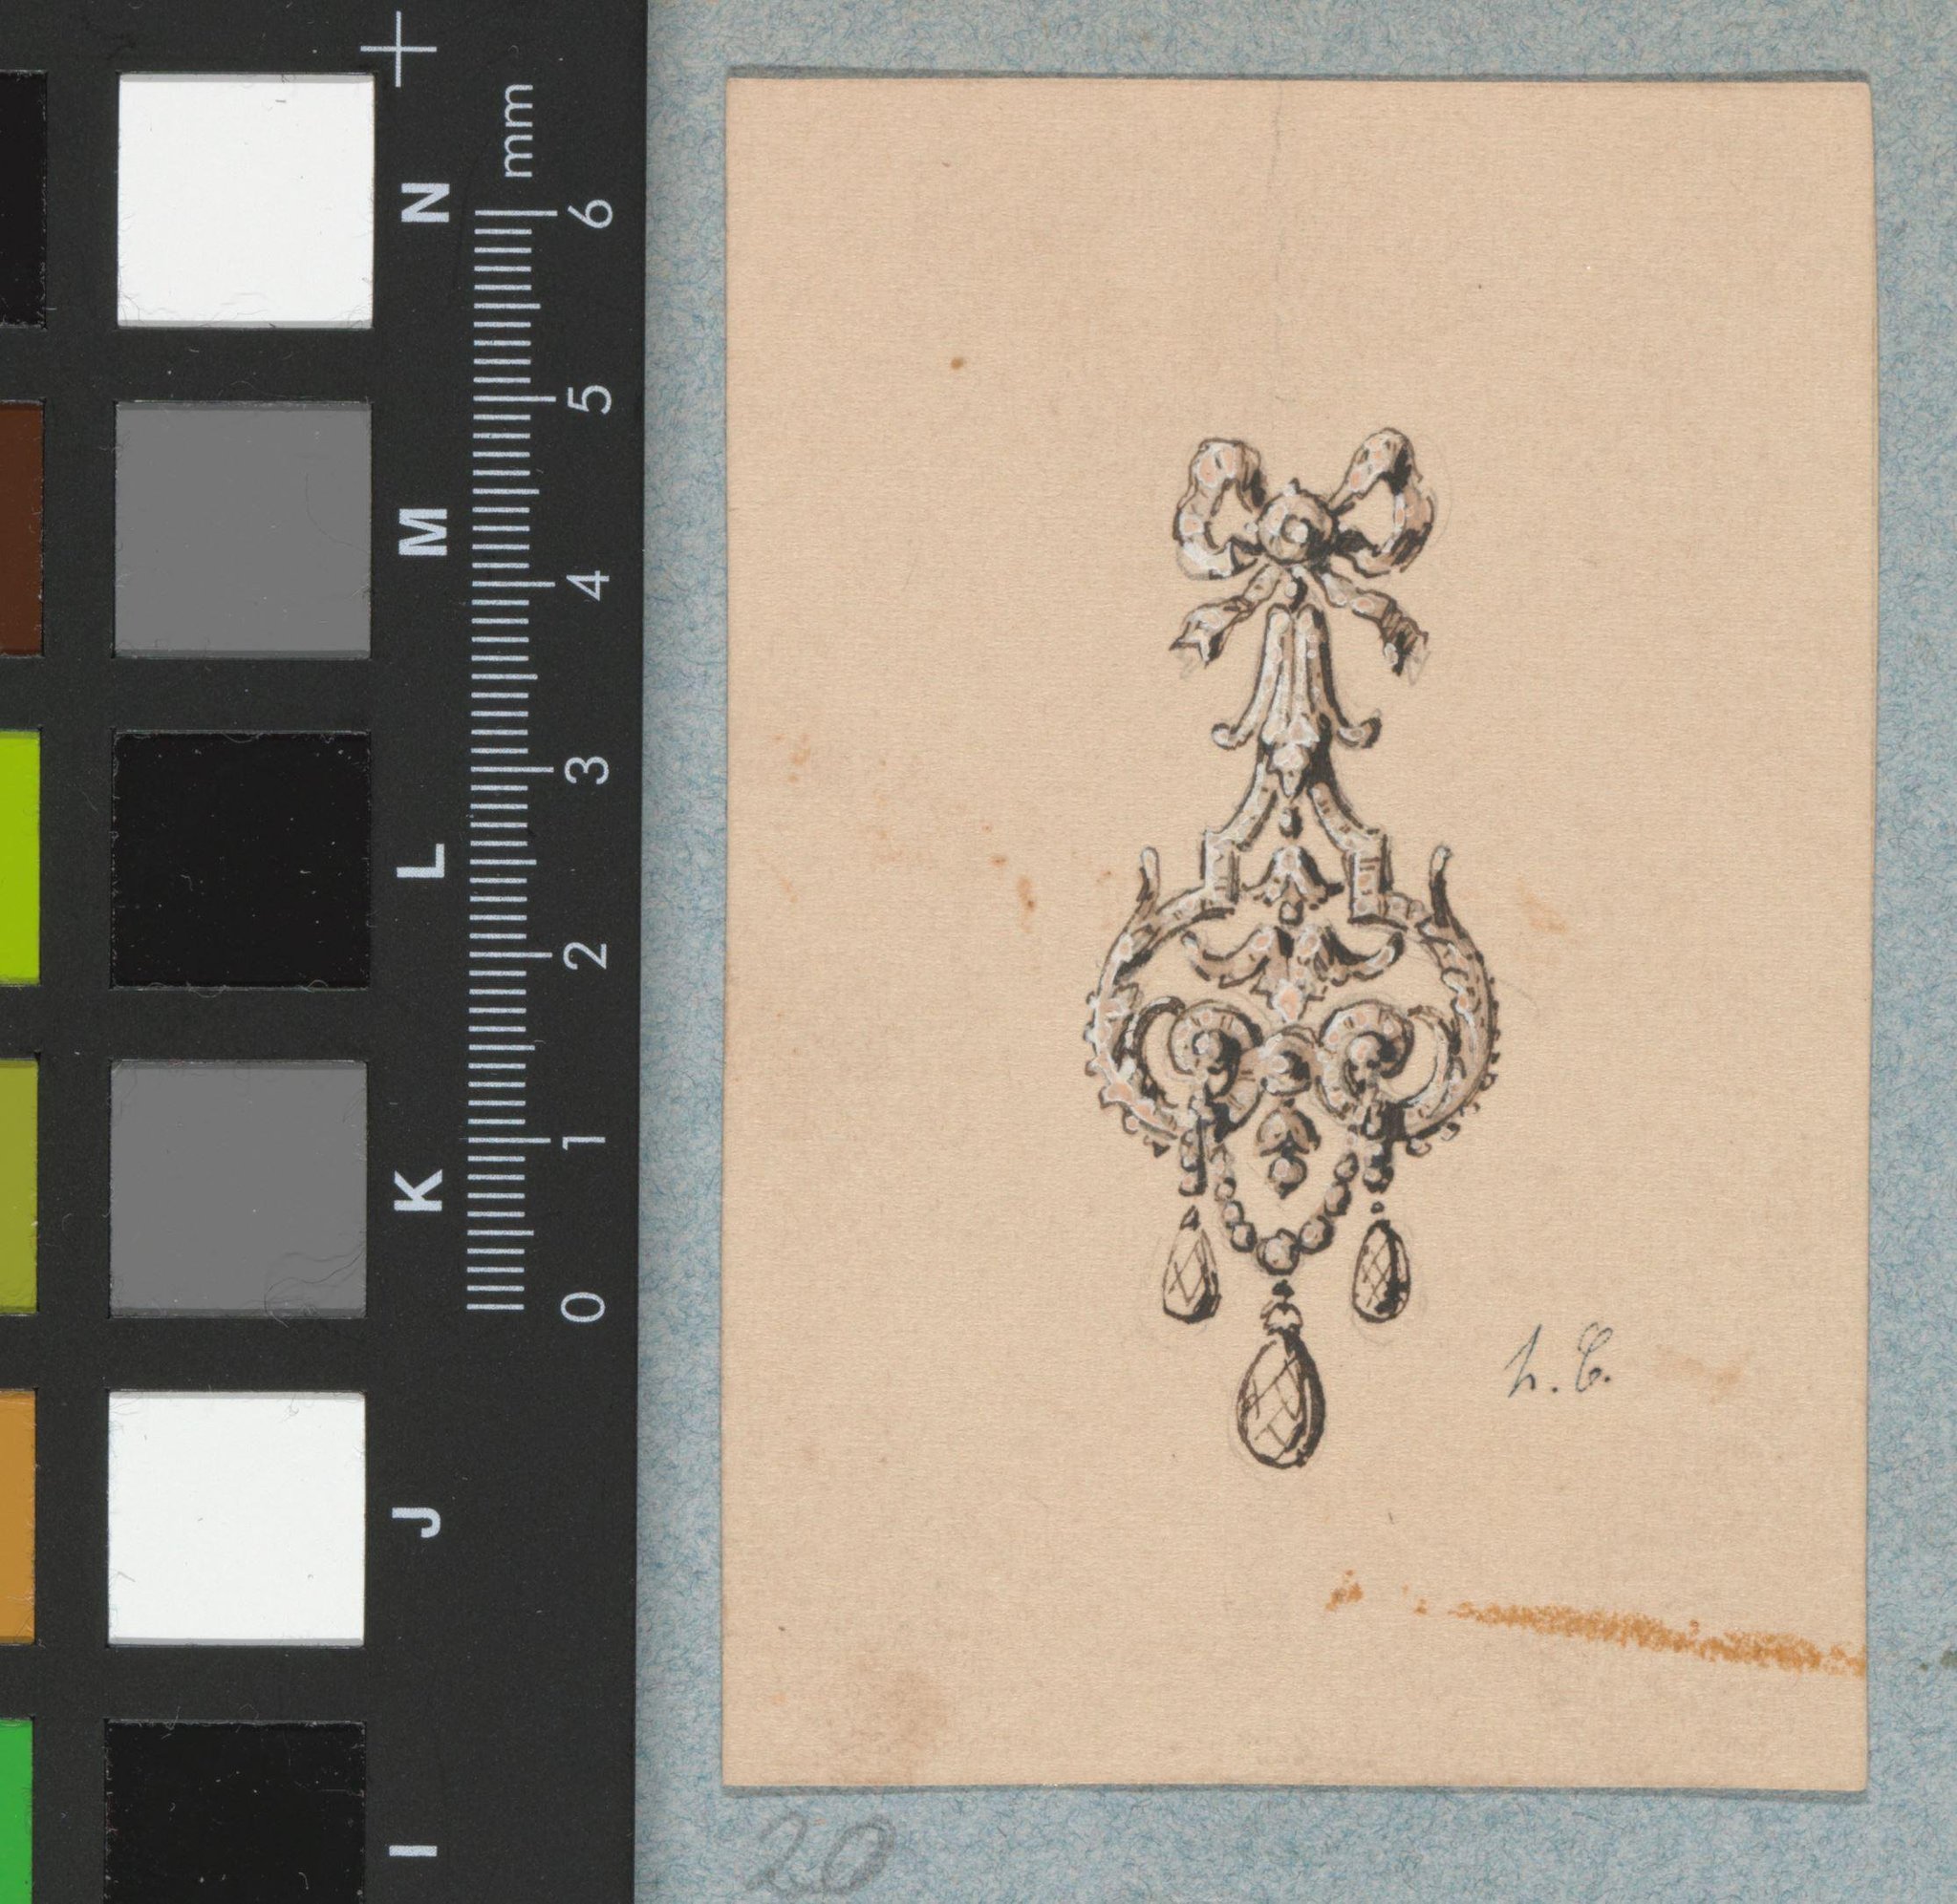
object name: design drawing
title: Two Designs for Pendants with Diamonds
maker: henri cameré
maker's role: designer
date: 1864-1894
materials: paint, ink, paper, watercolor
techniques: pen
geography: paris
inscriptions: signature: ‘h.C.’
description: In 1867 rich diamond deposits were discovered along the Orange River in South Africa. Diamonds subsequently flooded the European market. Their price went down, and they became more widely available and affordable than in previous centuries. Notice the three drop-shaped diamonds hanging from the pendant in the top drawing; this type of cut is called briolette. The cruciform pendant is set with brilliant-cut diamonds.